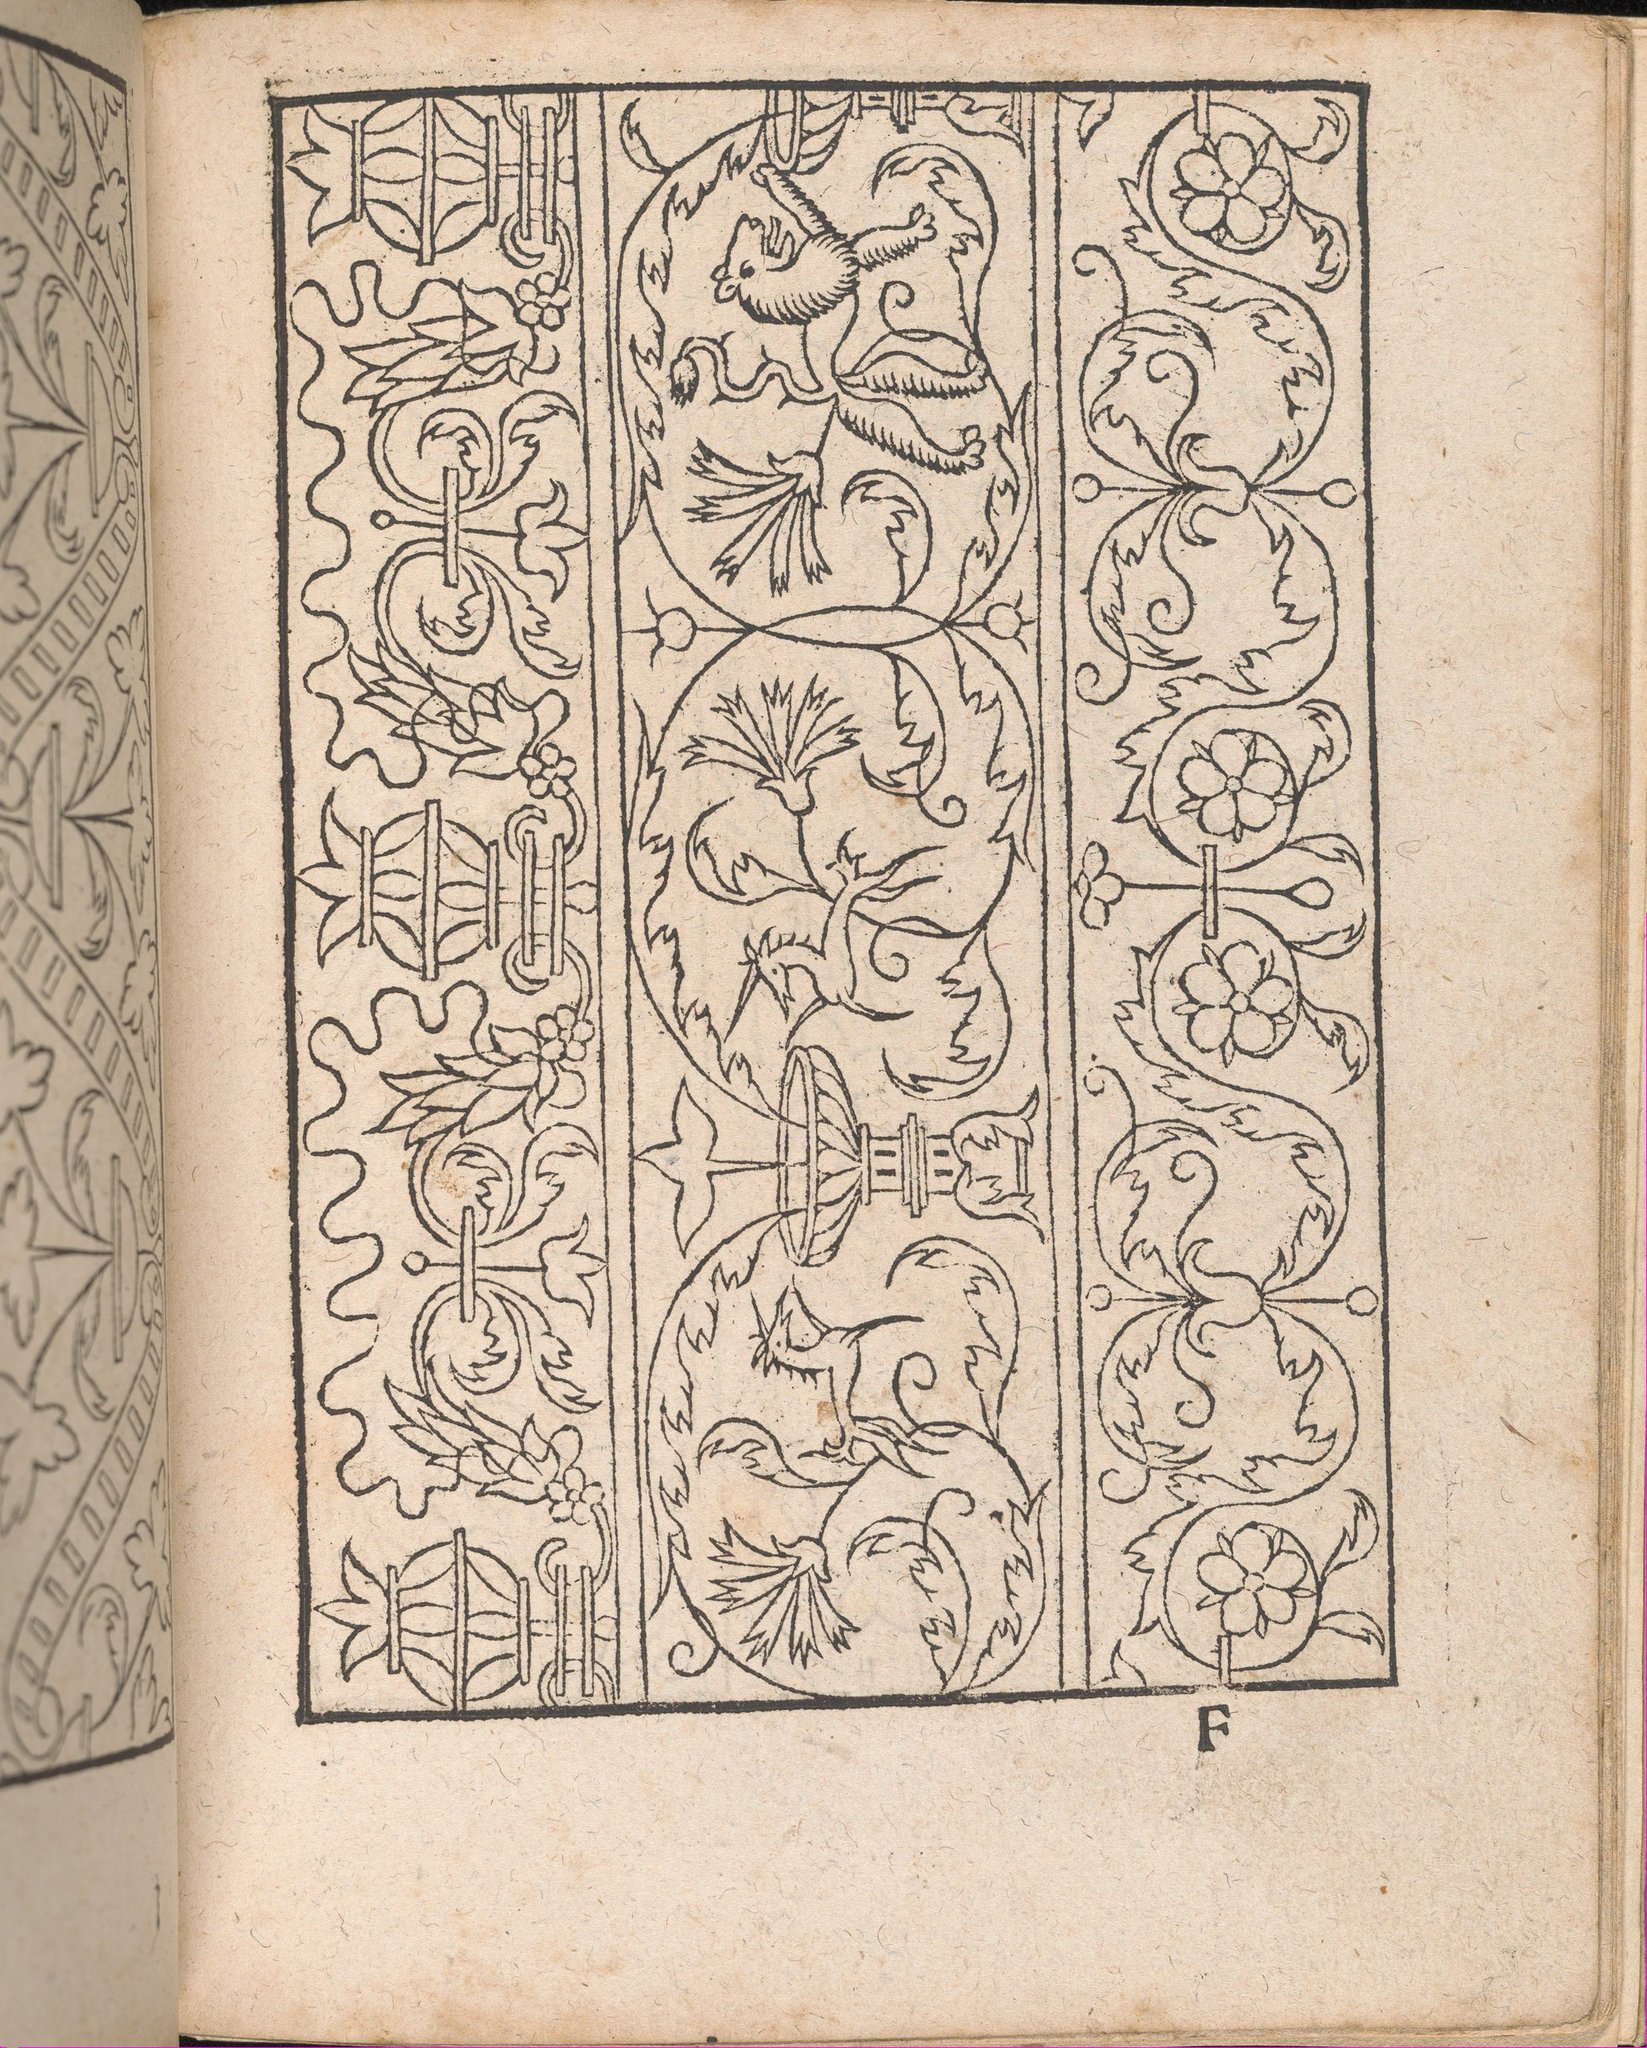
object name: book print ornament architecture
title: New Modelbüch allen Nägerin u. Sydenstickern (Page 21r)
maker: hans hoffman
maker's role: designer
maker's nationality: german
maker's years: 1556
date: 1556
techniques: woodcut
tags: ornament